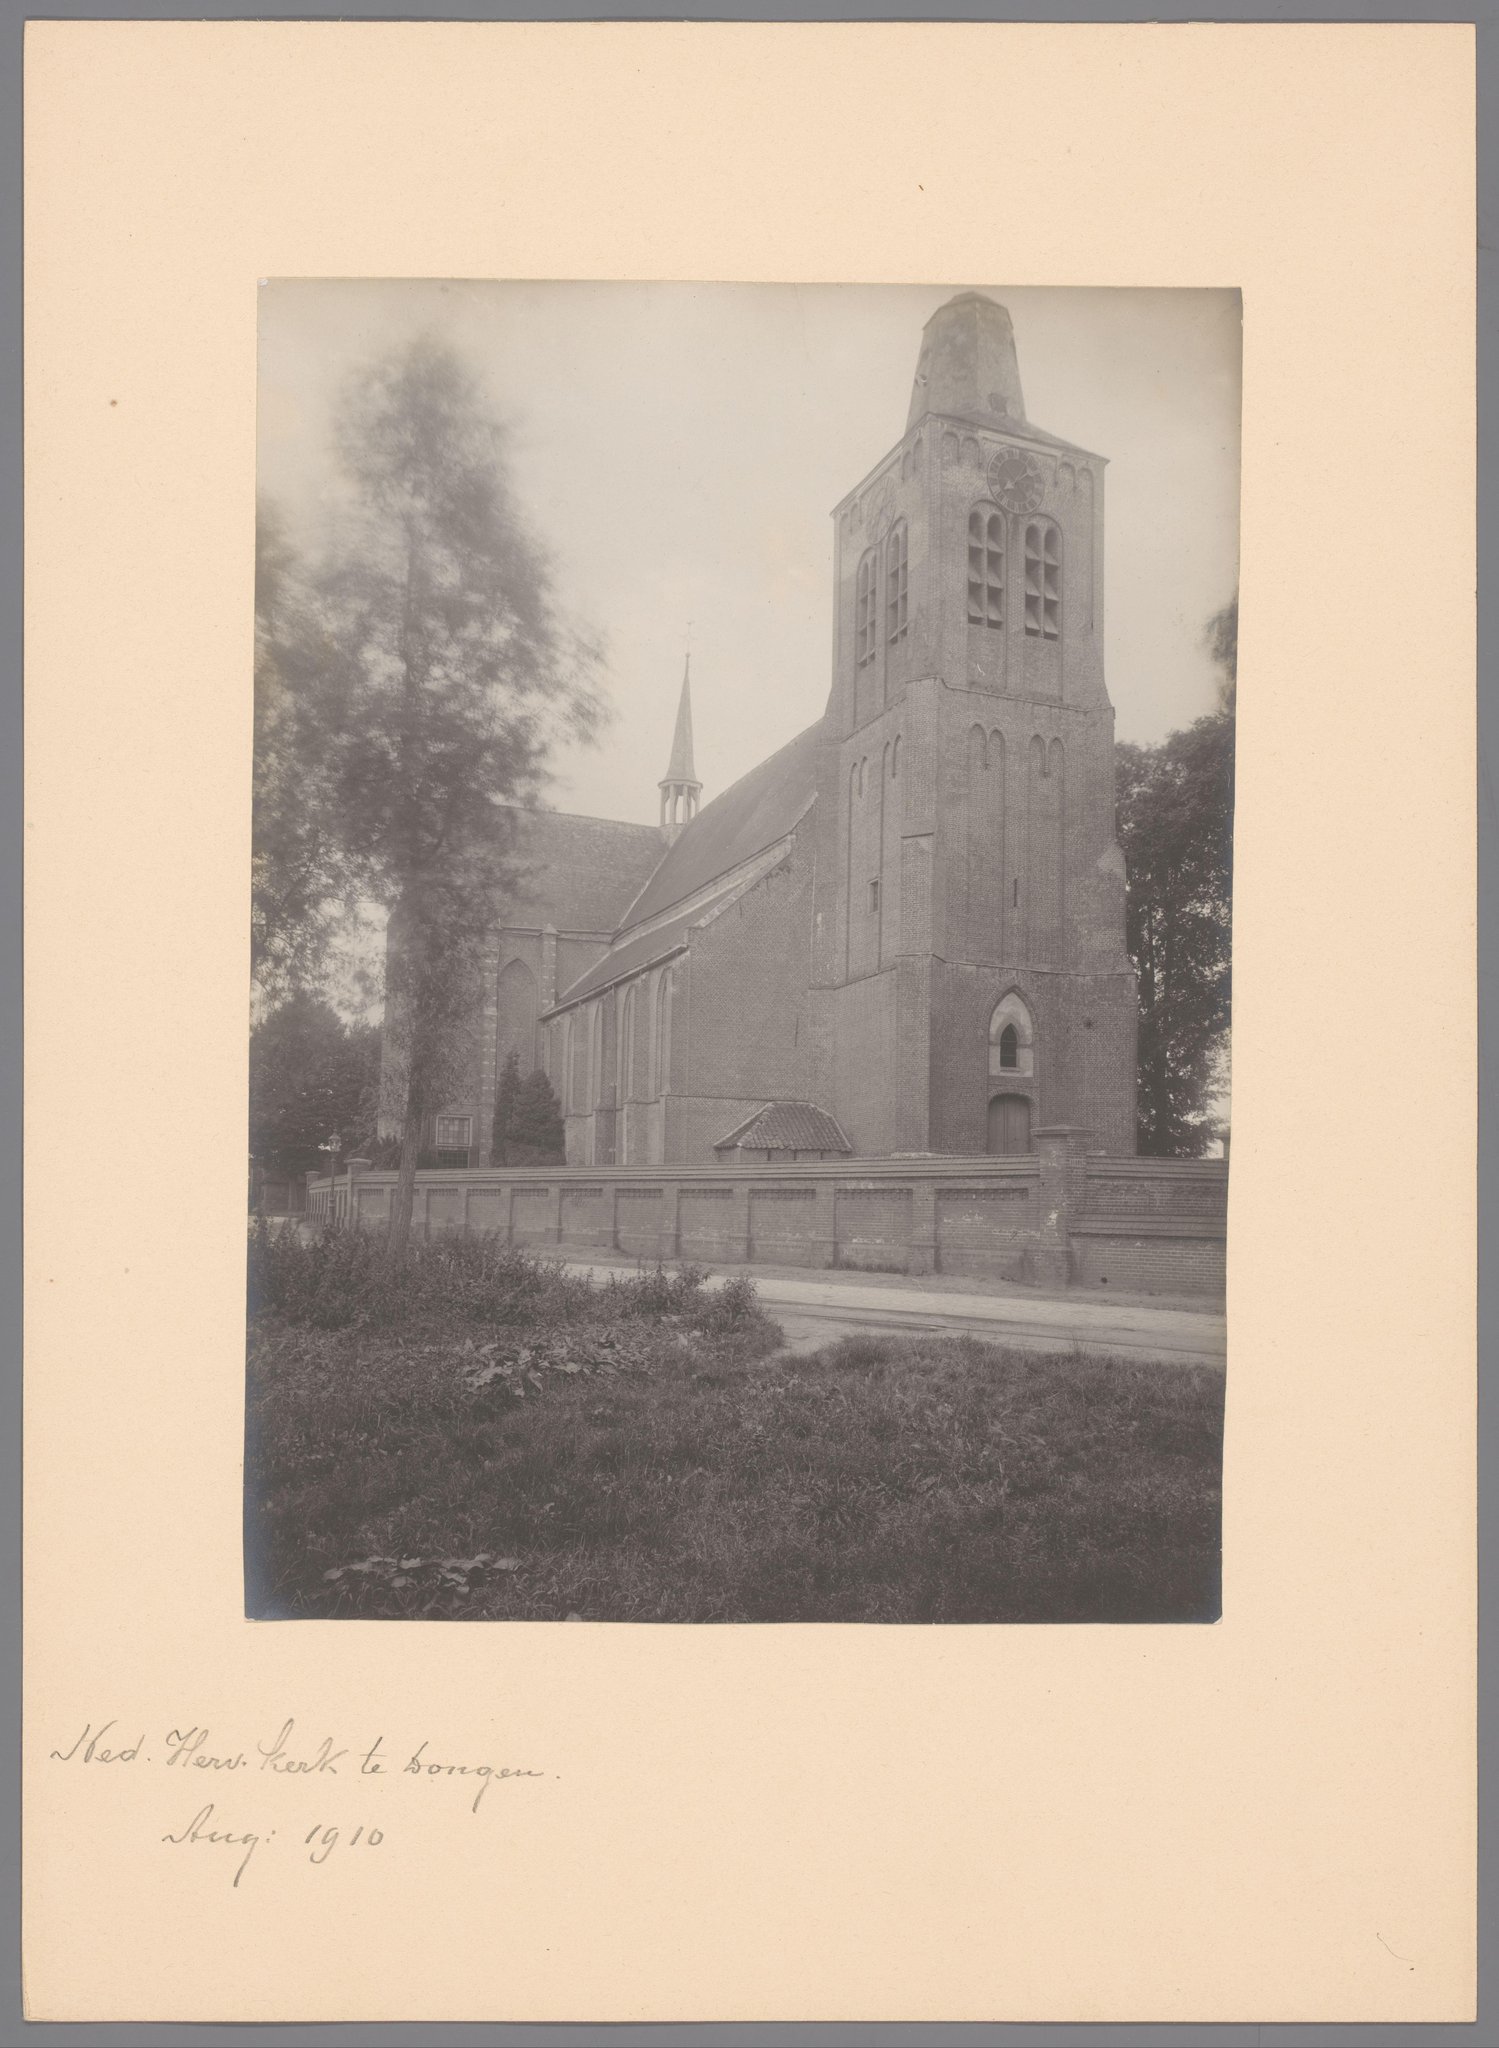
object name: photograph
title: Gezicht op de Hervormde Kerk te Dongen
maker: anoniem (monumentenzorg)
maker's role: fotograaf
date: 1910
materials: cardboard, photographic support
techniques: gelatin silver print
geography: dongen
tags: church (exterior)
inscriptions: annotation: ‘Ned. Herv. kerk te Dongen/ Aug: 1910’